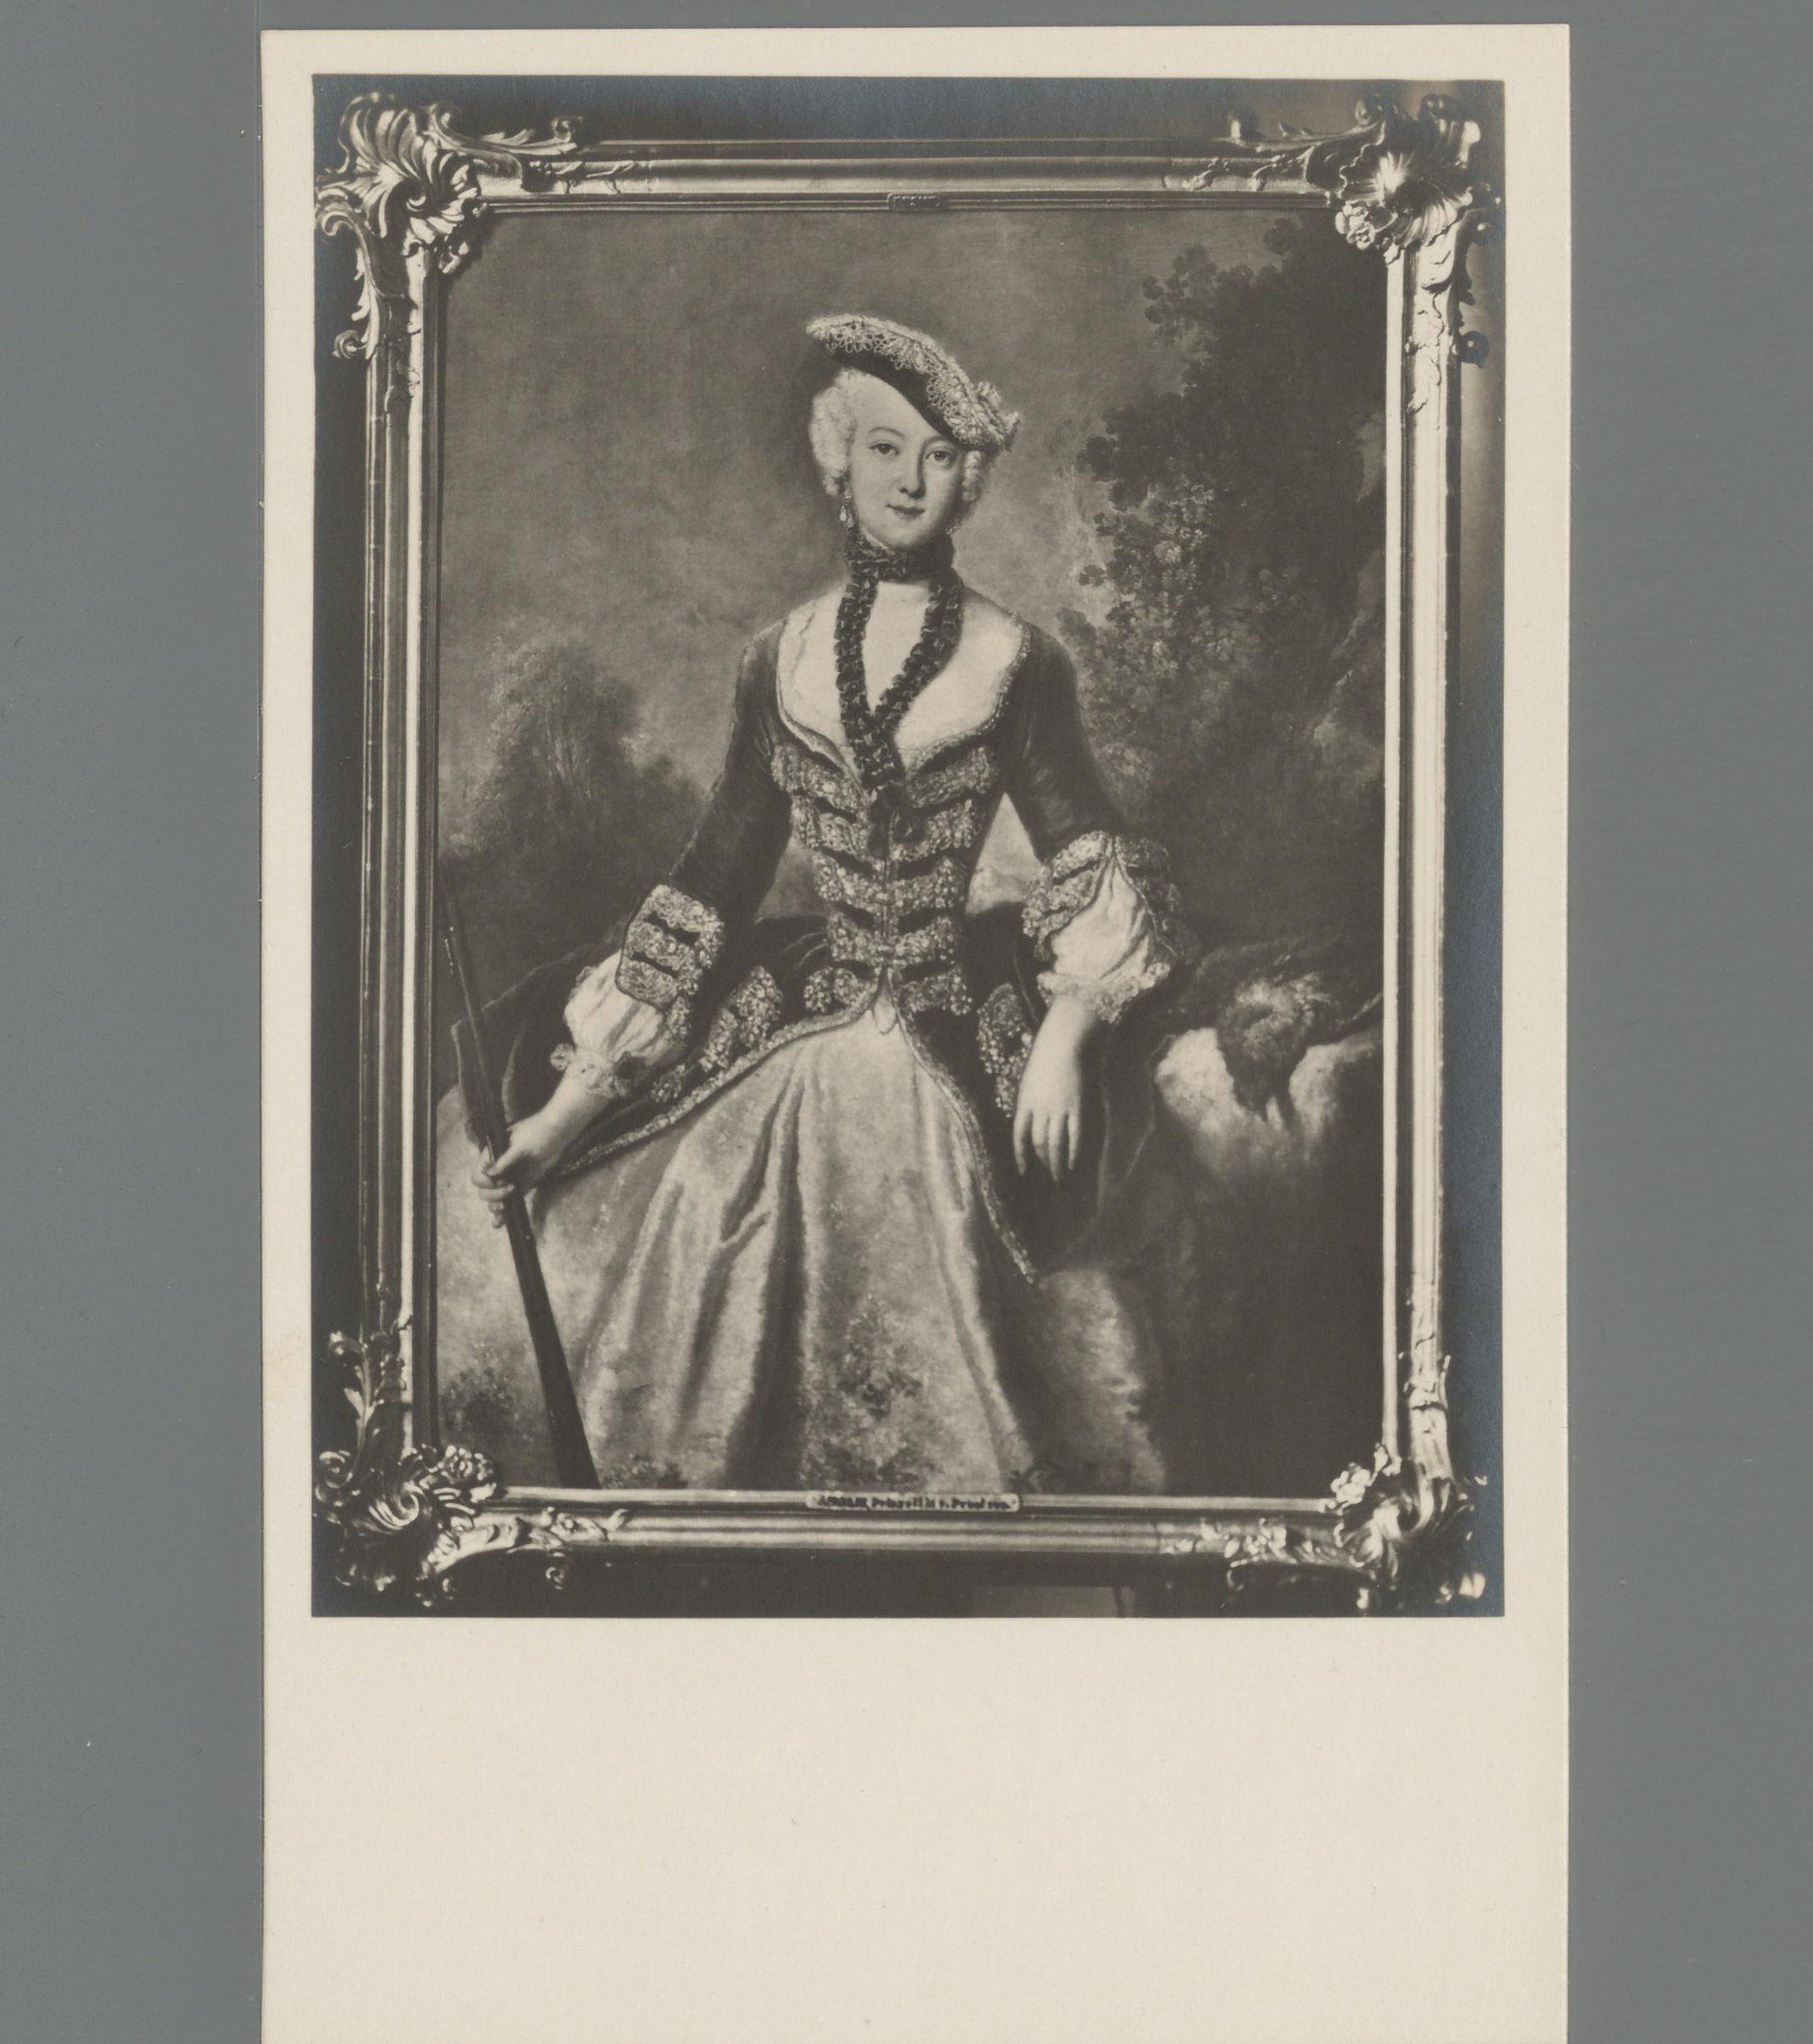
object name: ansichtkaart, prentbriefkaart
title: Schlossmuseum, Berlin. Antoine Fesne (1683-1757). Frauenbildnis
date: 1918-1930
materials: photographic support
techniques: photography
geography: berlin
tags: castle, permanent exhibition, museum, picture, painting